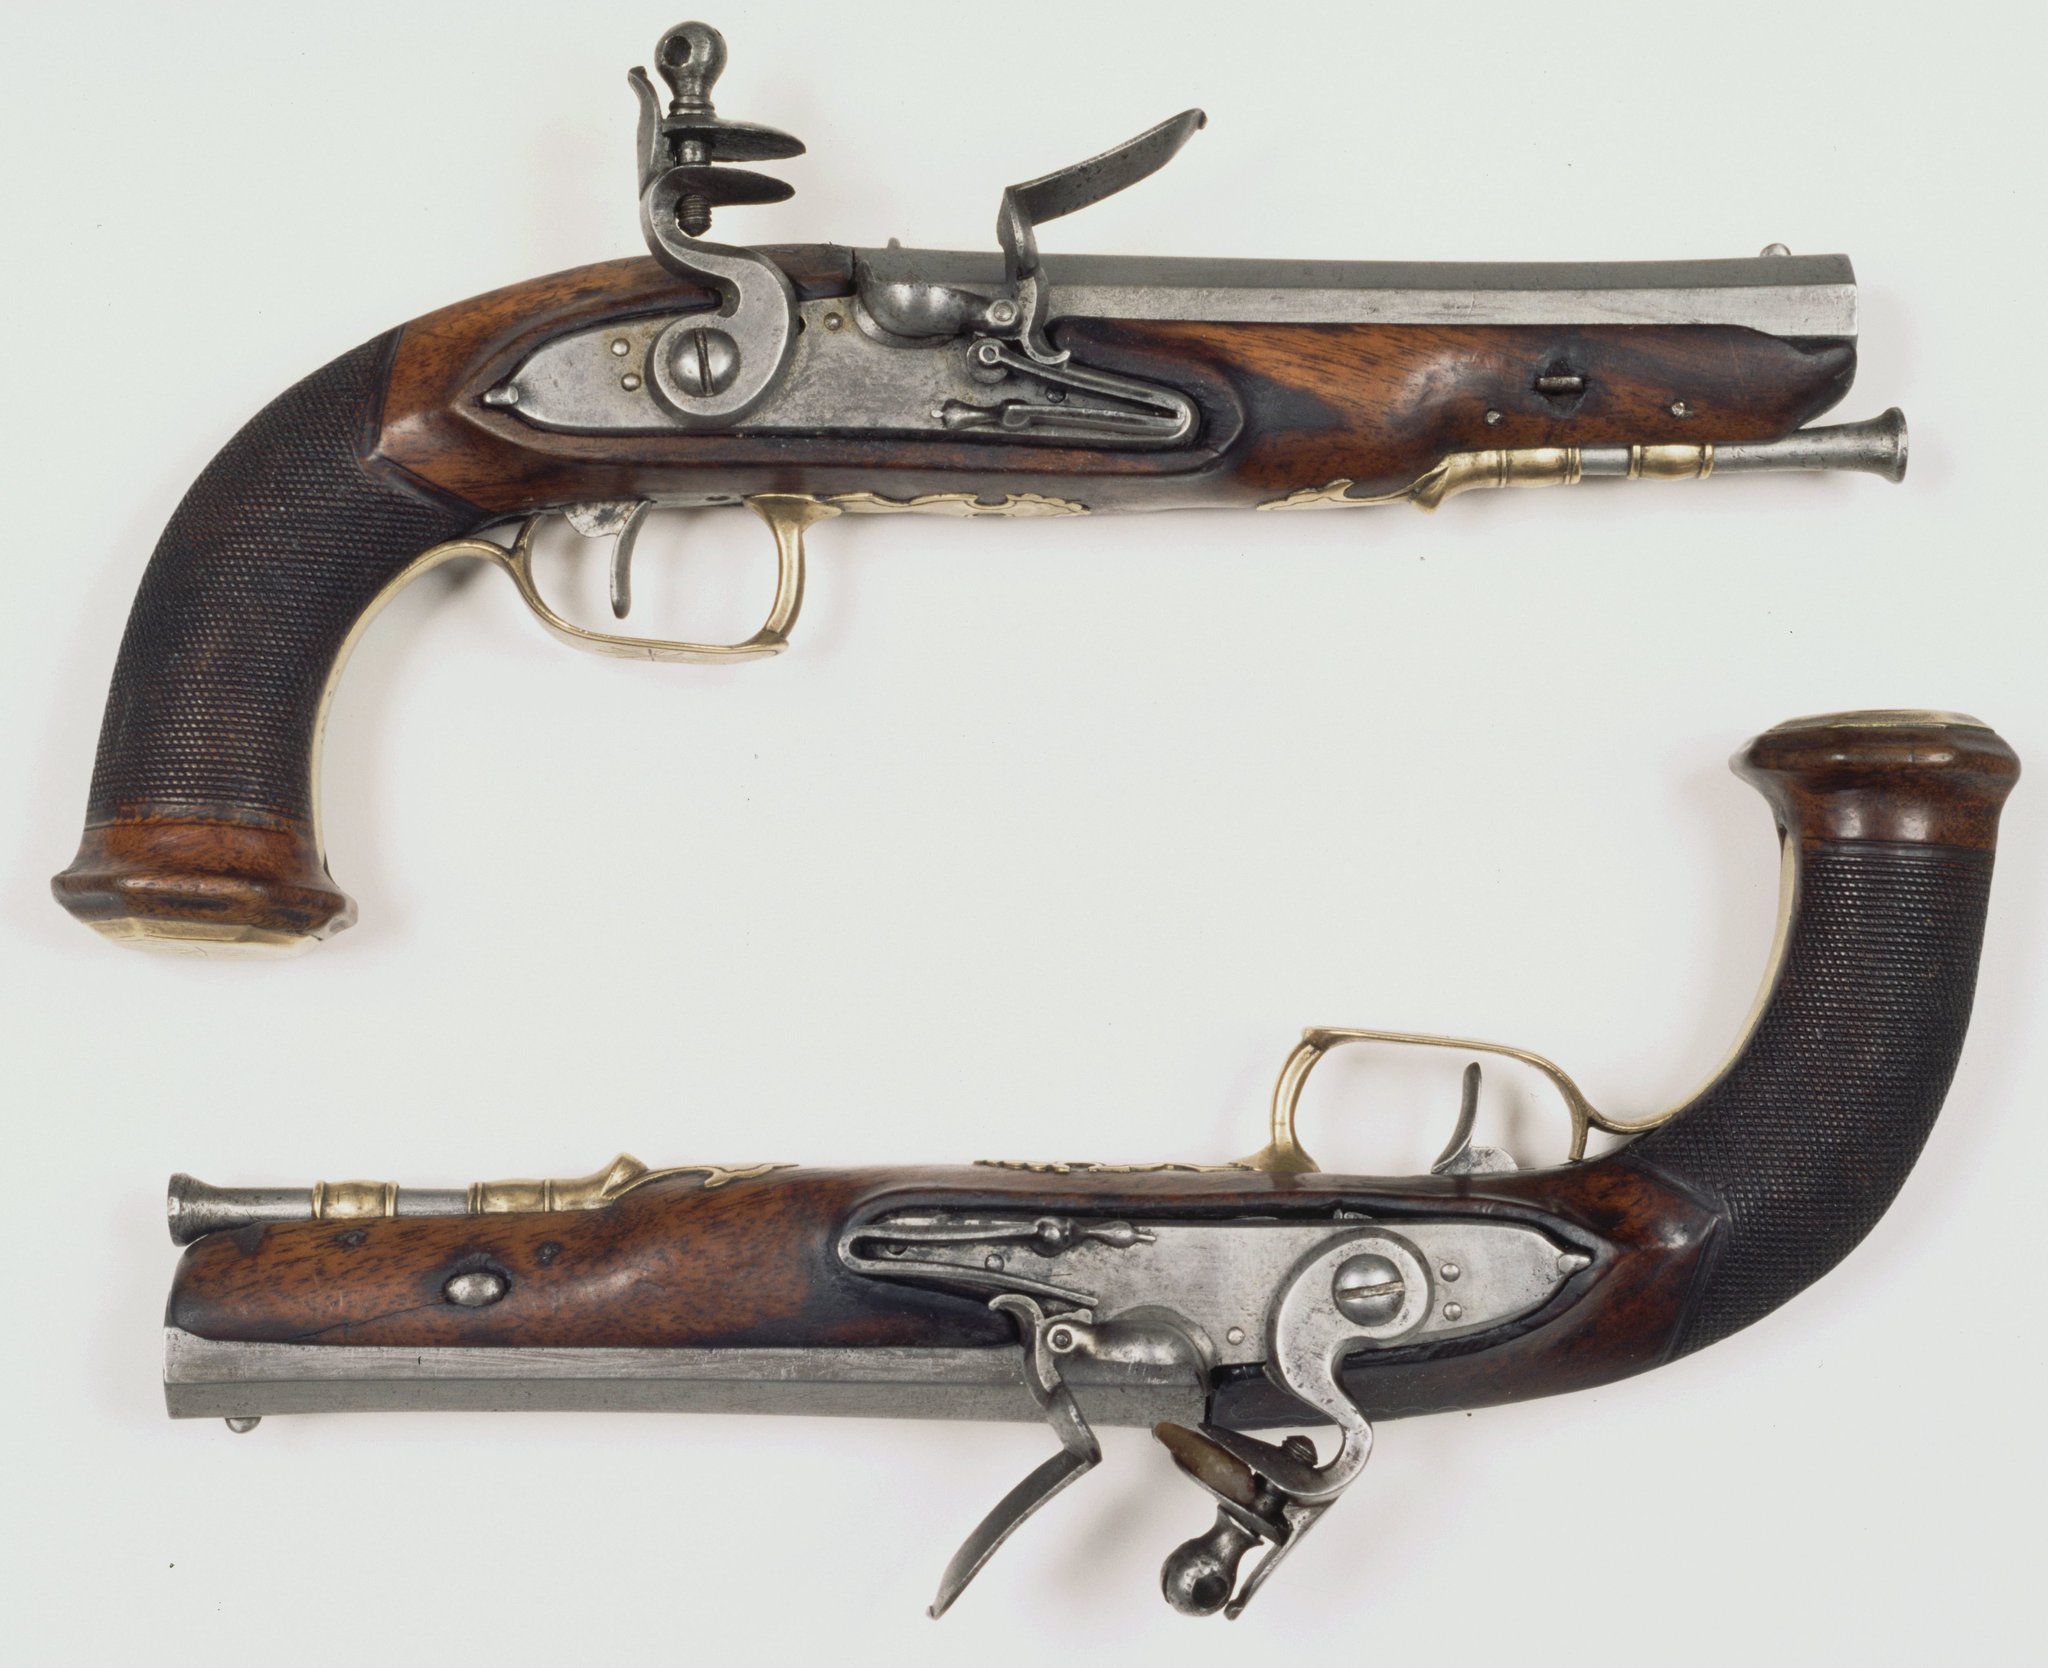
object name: flintlock pistol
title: Holsterpistool met vuursteenslot van Jonkheer H.D. Hooft van Woudenberg en Geerestein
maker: Anonymous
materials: bronze, iron, wood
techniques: cutting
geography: western europe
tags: amsterdam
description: Holsterpistool met vuursteenslot, deel van koppel. Achtkantige loop. Vizierkorrel en kap van ijzer. Vlakke slotplaat. Twee bronzen zijplaten. Bronzen beslag met bewerkte greep. IJzeren laadstok. Loop fijn getrokken. Pistool van Jonkheer H.D. Hooft van Woudenberg en Geerestein, oud luitenant der Amsterdamse Schutterij te paard, 1831.